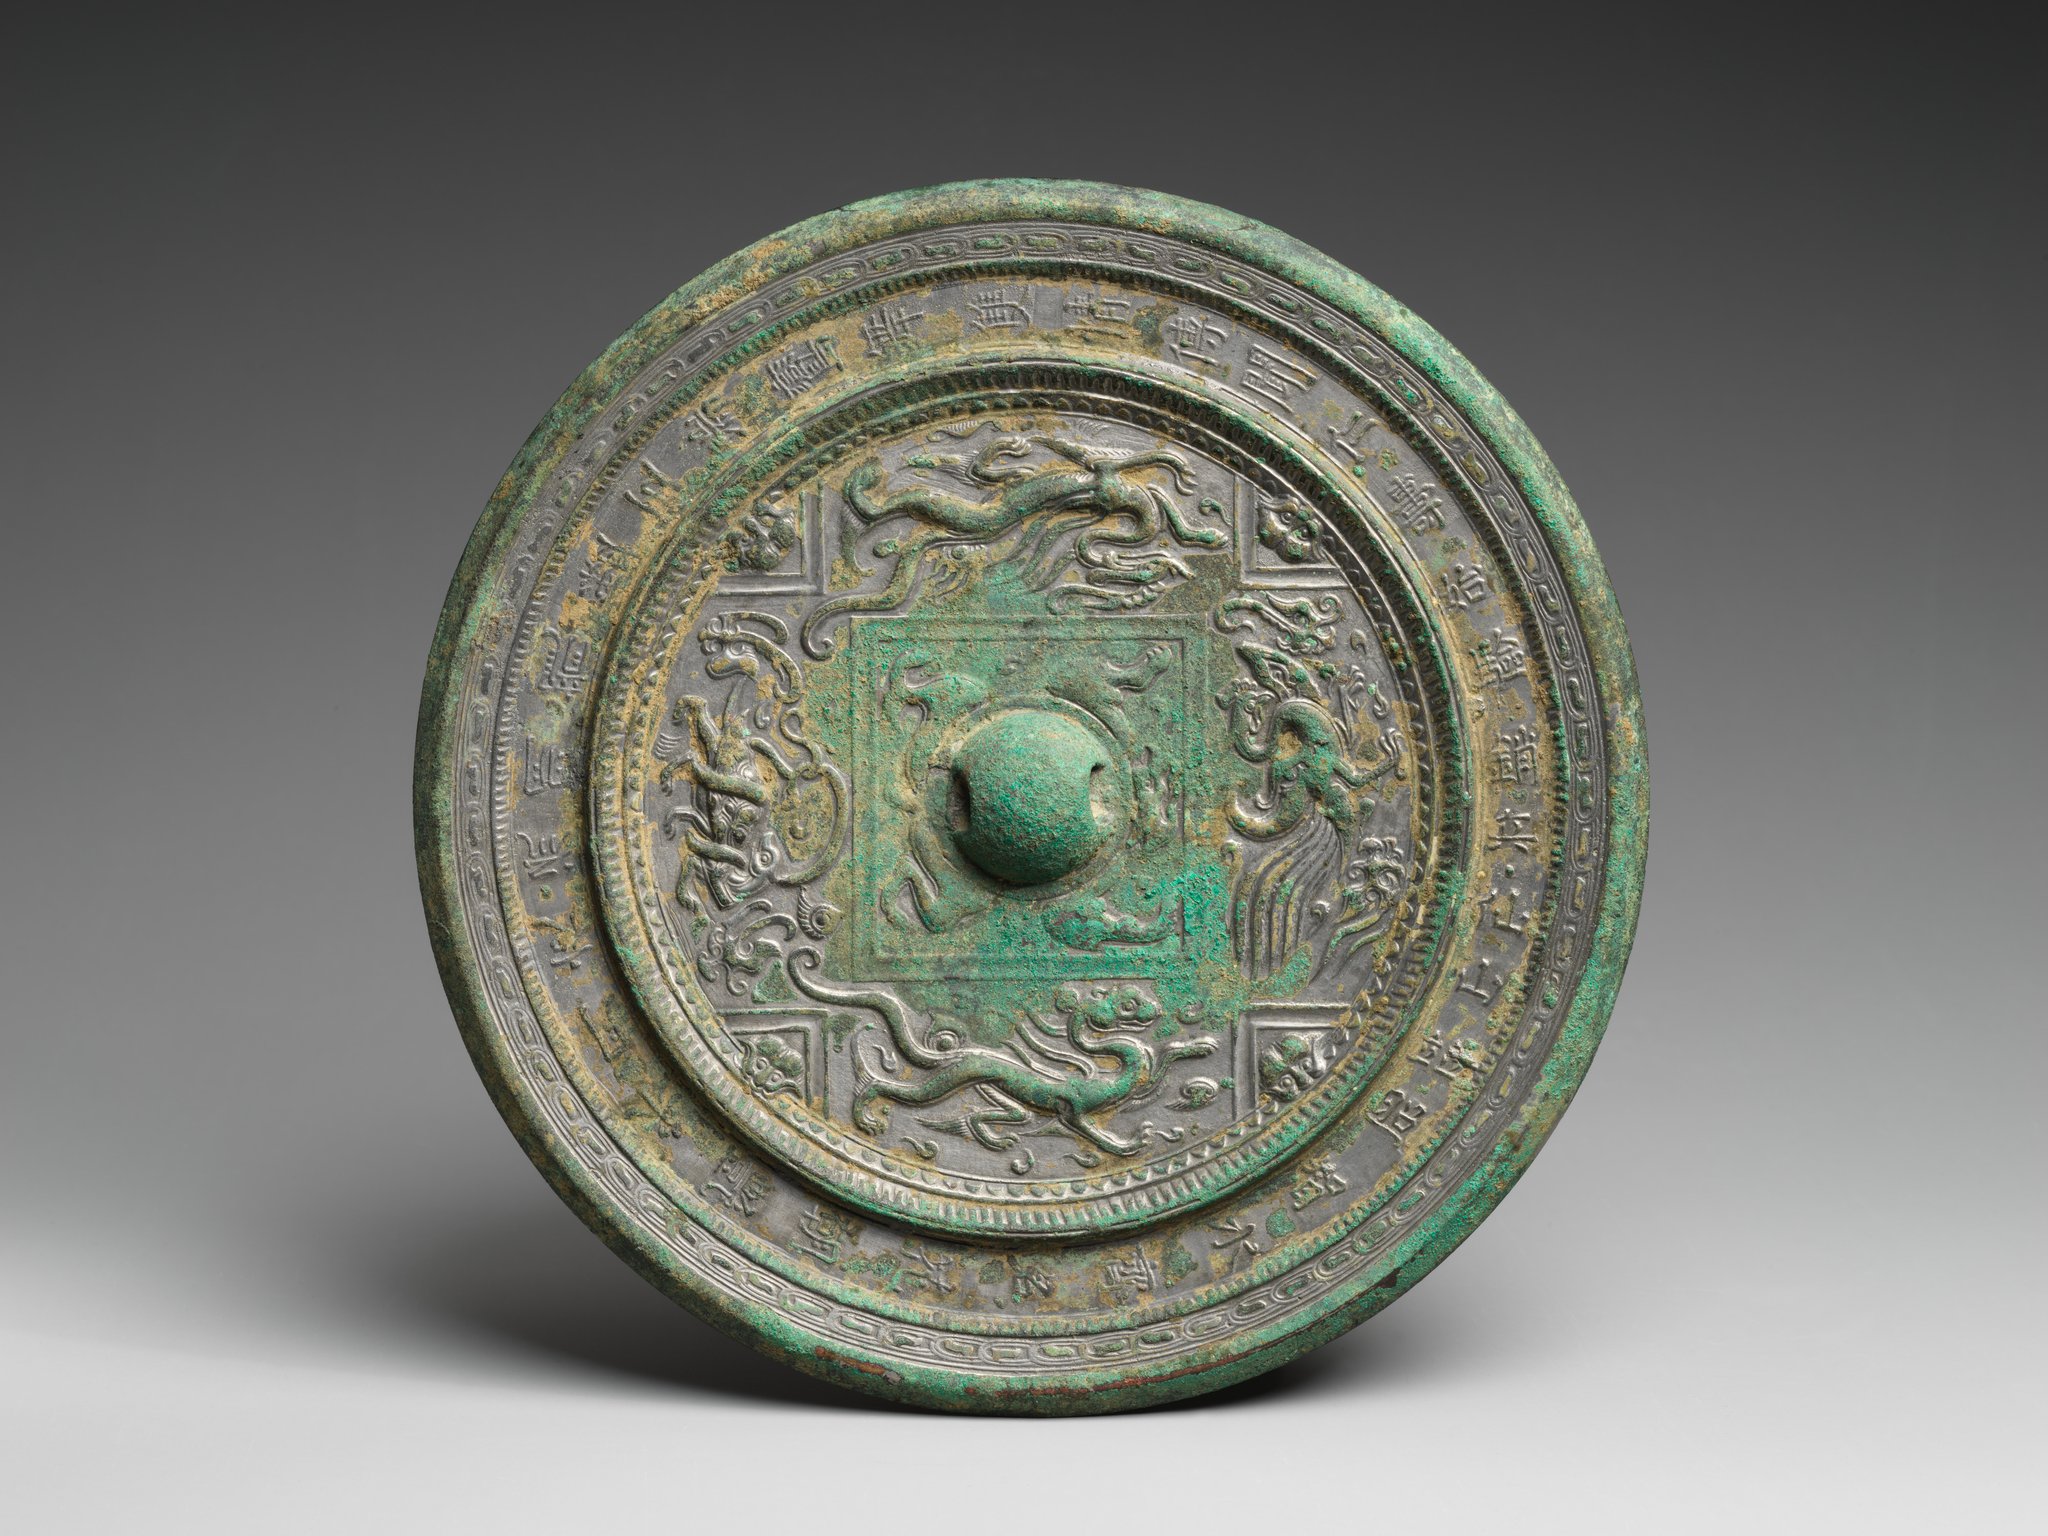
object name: mirror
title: Mirror with symbols of the four cardinal directions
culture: chinese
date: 601-700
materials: bronze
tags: birds,dragons,snakes,tigers,turtles